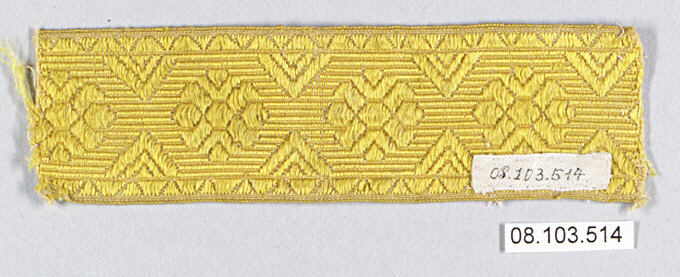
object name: galloon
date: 1701-1800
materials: cotton, silk